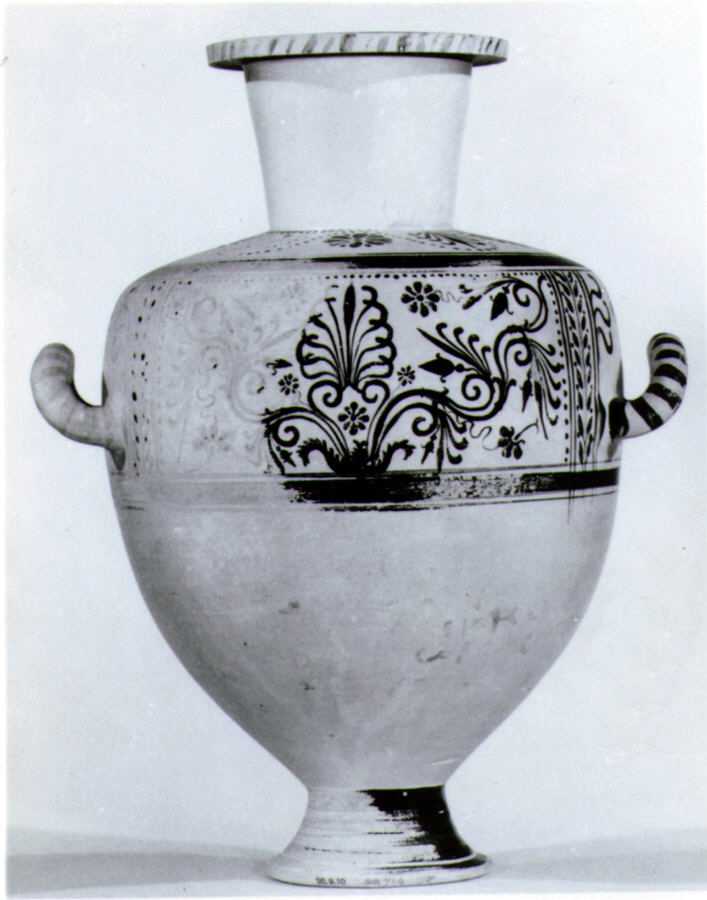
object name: hydria, hadra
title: Terracotta Hadra hydria (water jar)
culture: greek, cretan or ptolemaic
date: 220 BCE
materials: terracotta